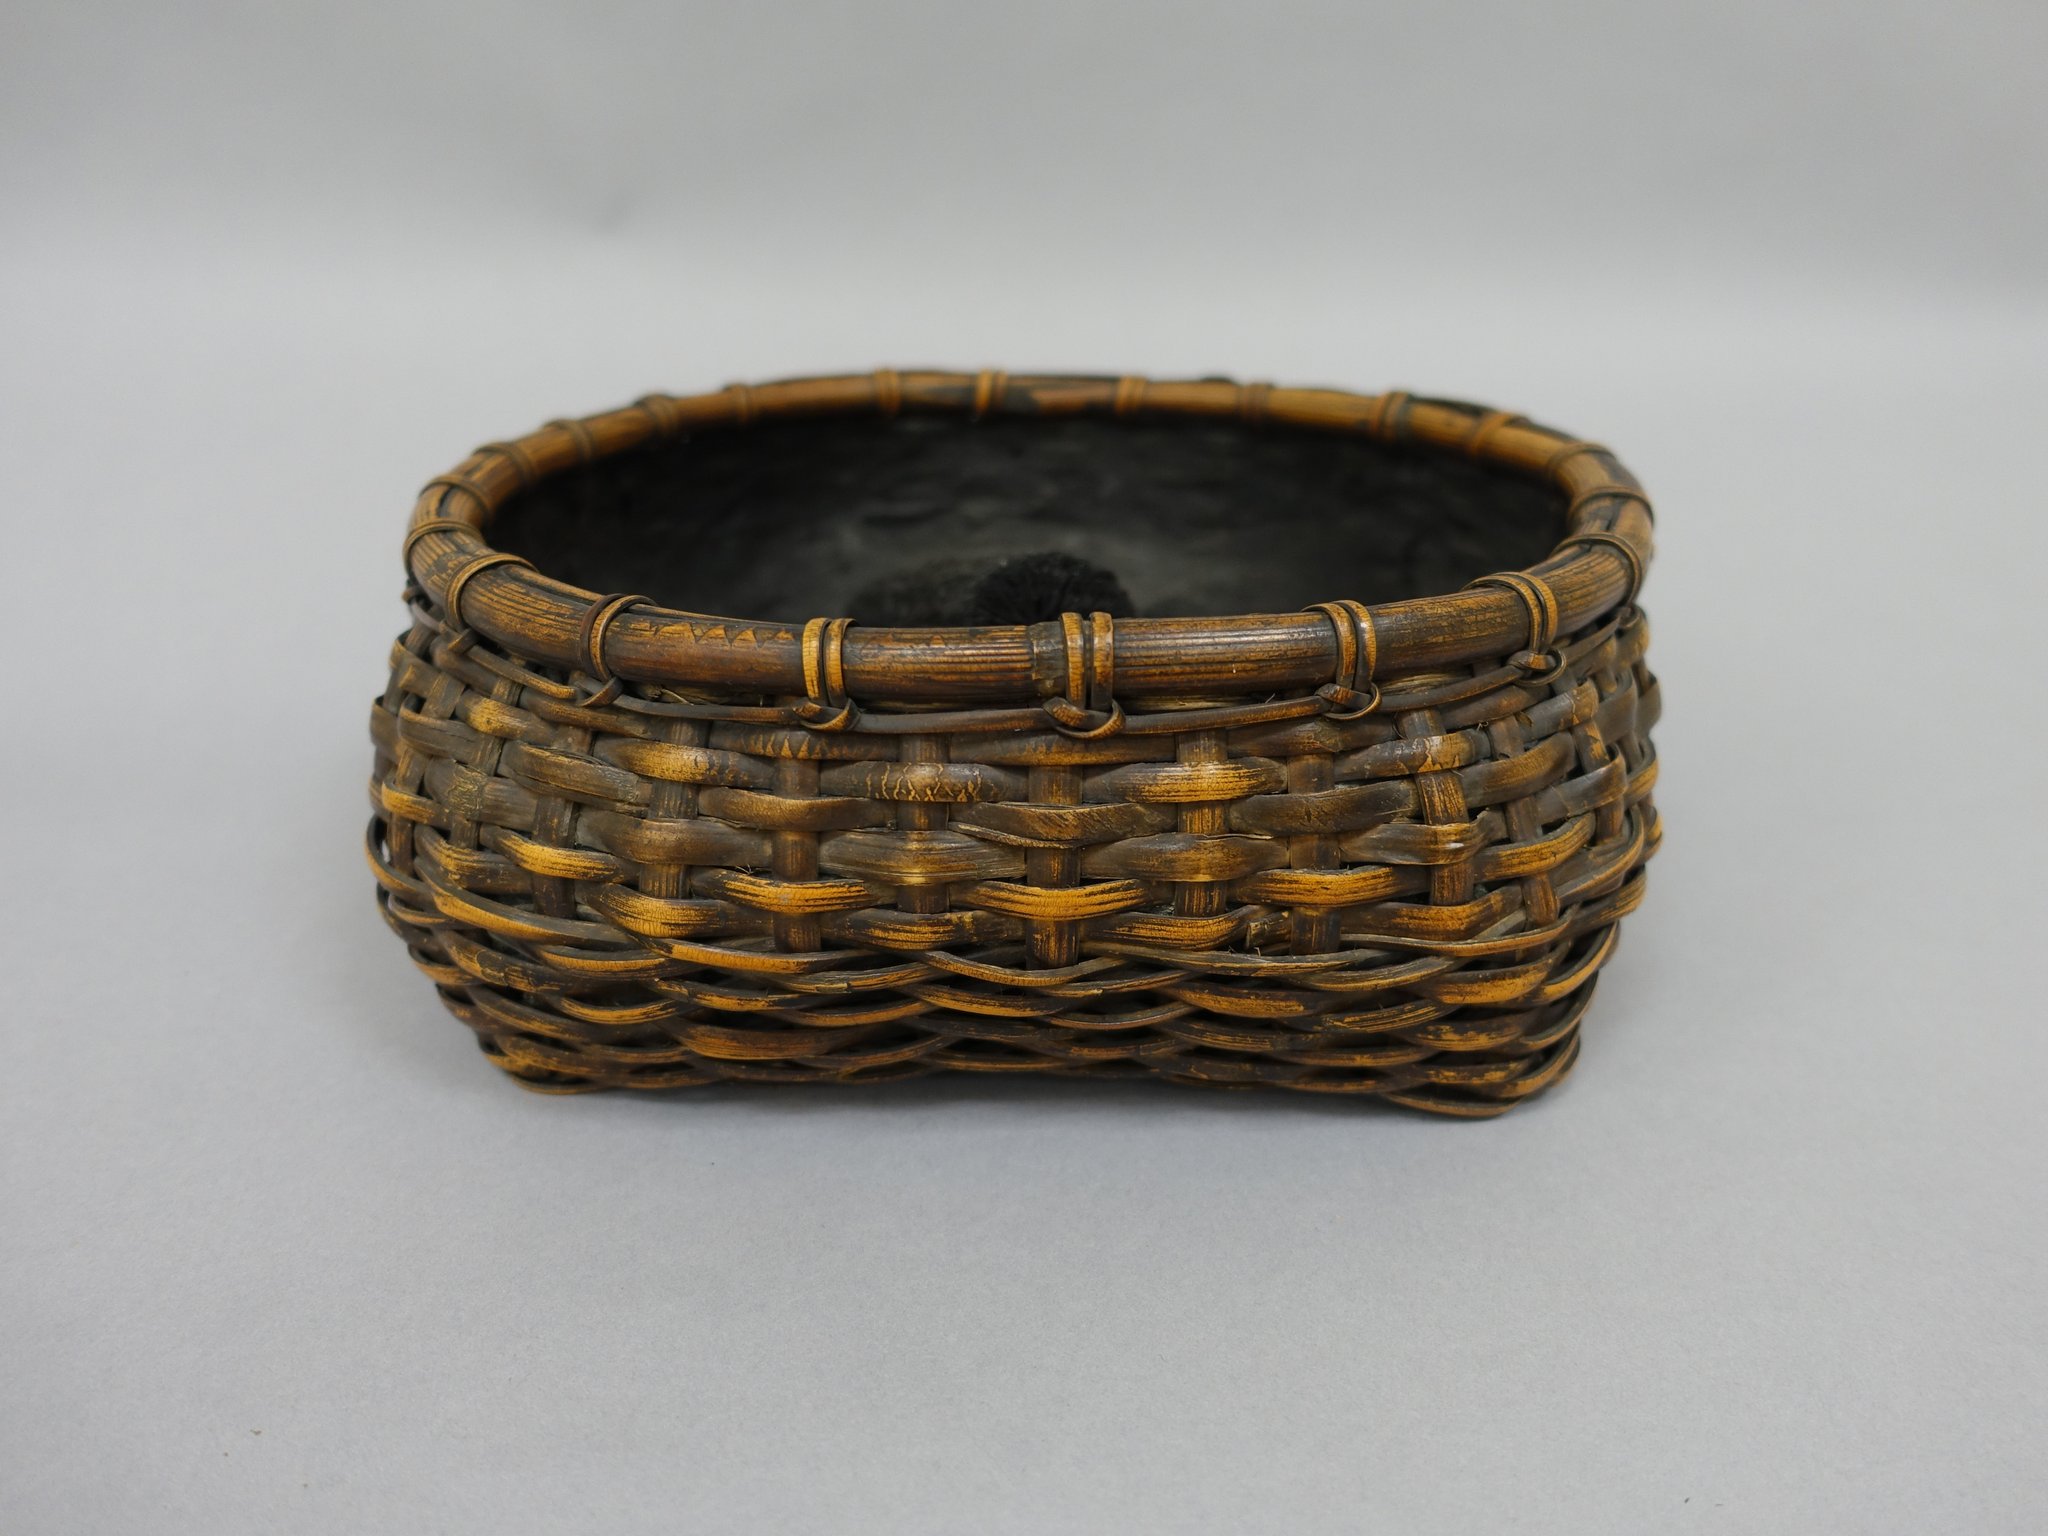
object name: basket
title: Charcoal Basket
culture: japanese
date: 1801-1900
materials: bamboo